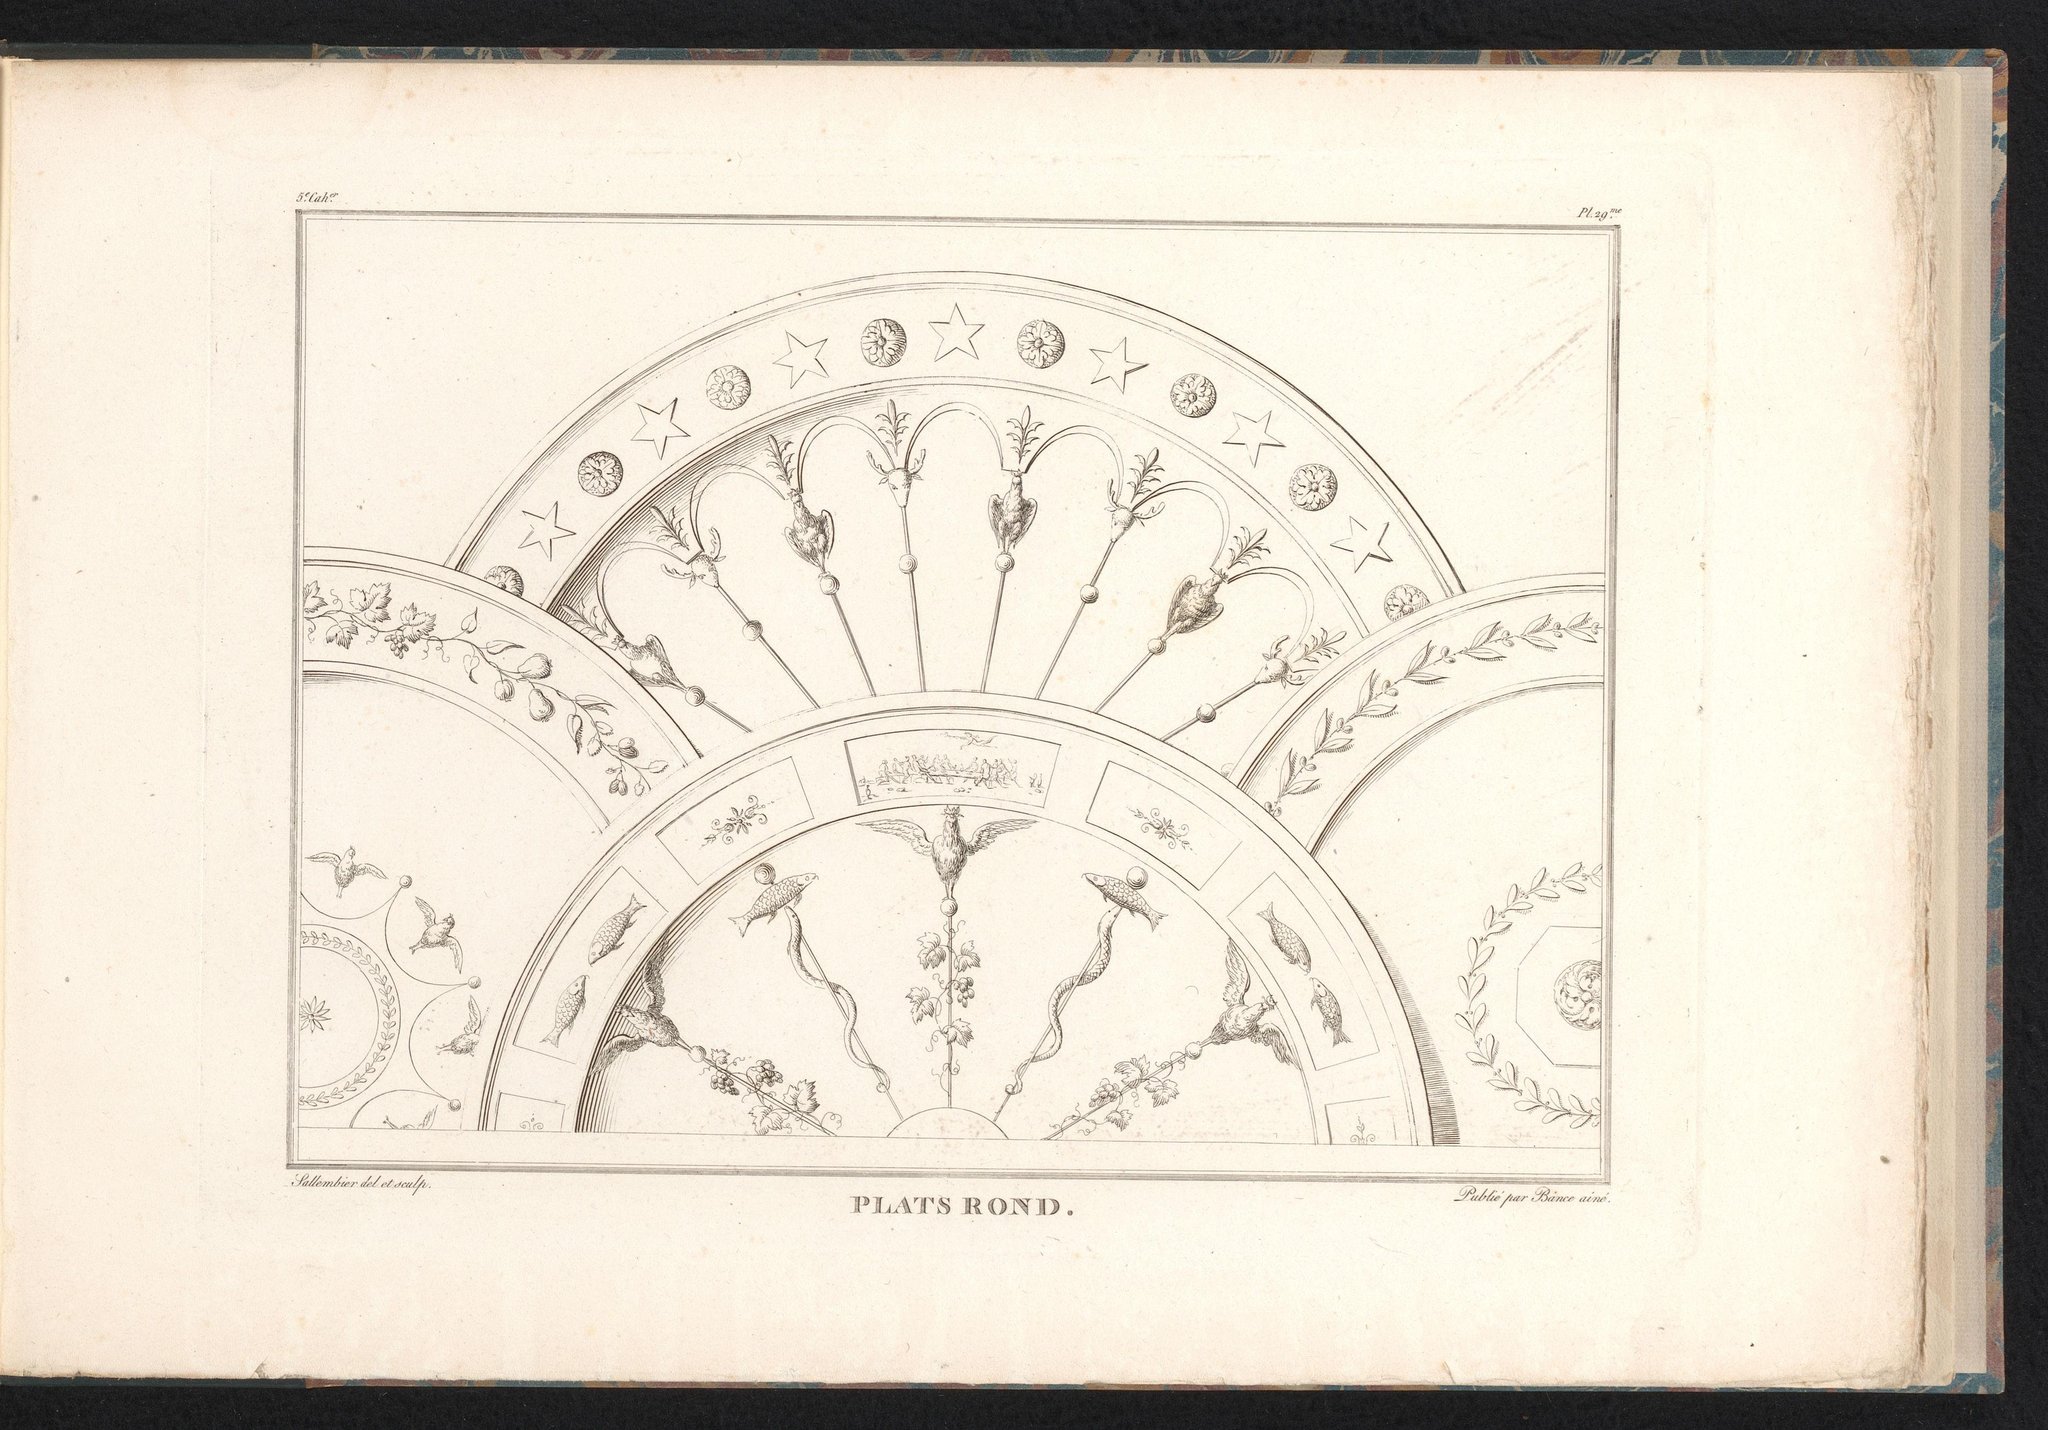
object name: album leaf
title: Ronde schalen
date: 1805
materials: paper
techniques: etching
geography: paris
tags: hoofed animals: deer, birds, dish, plate, saucer, eels: eel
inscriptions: number: ‘5.e Cah.er’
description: Ontwerpen voor vier platte ronde schalen of borden, met onder meer vogels, herten, vissen en palingen. Prent maakt deel uit van een album.